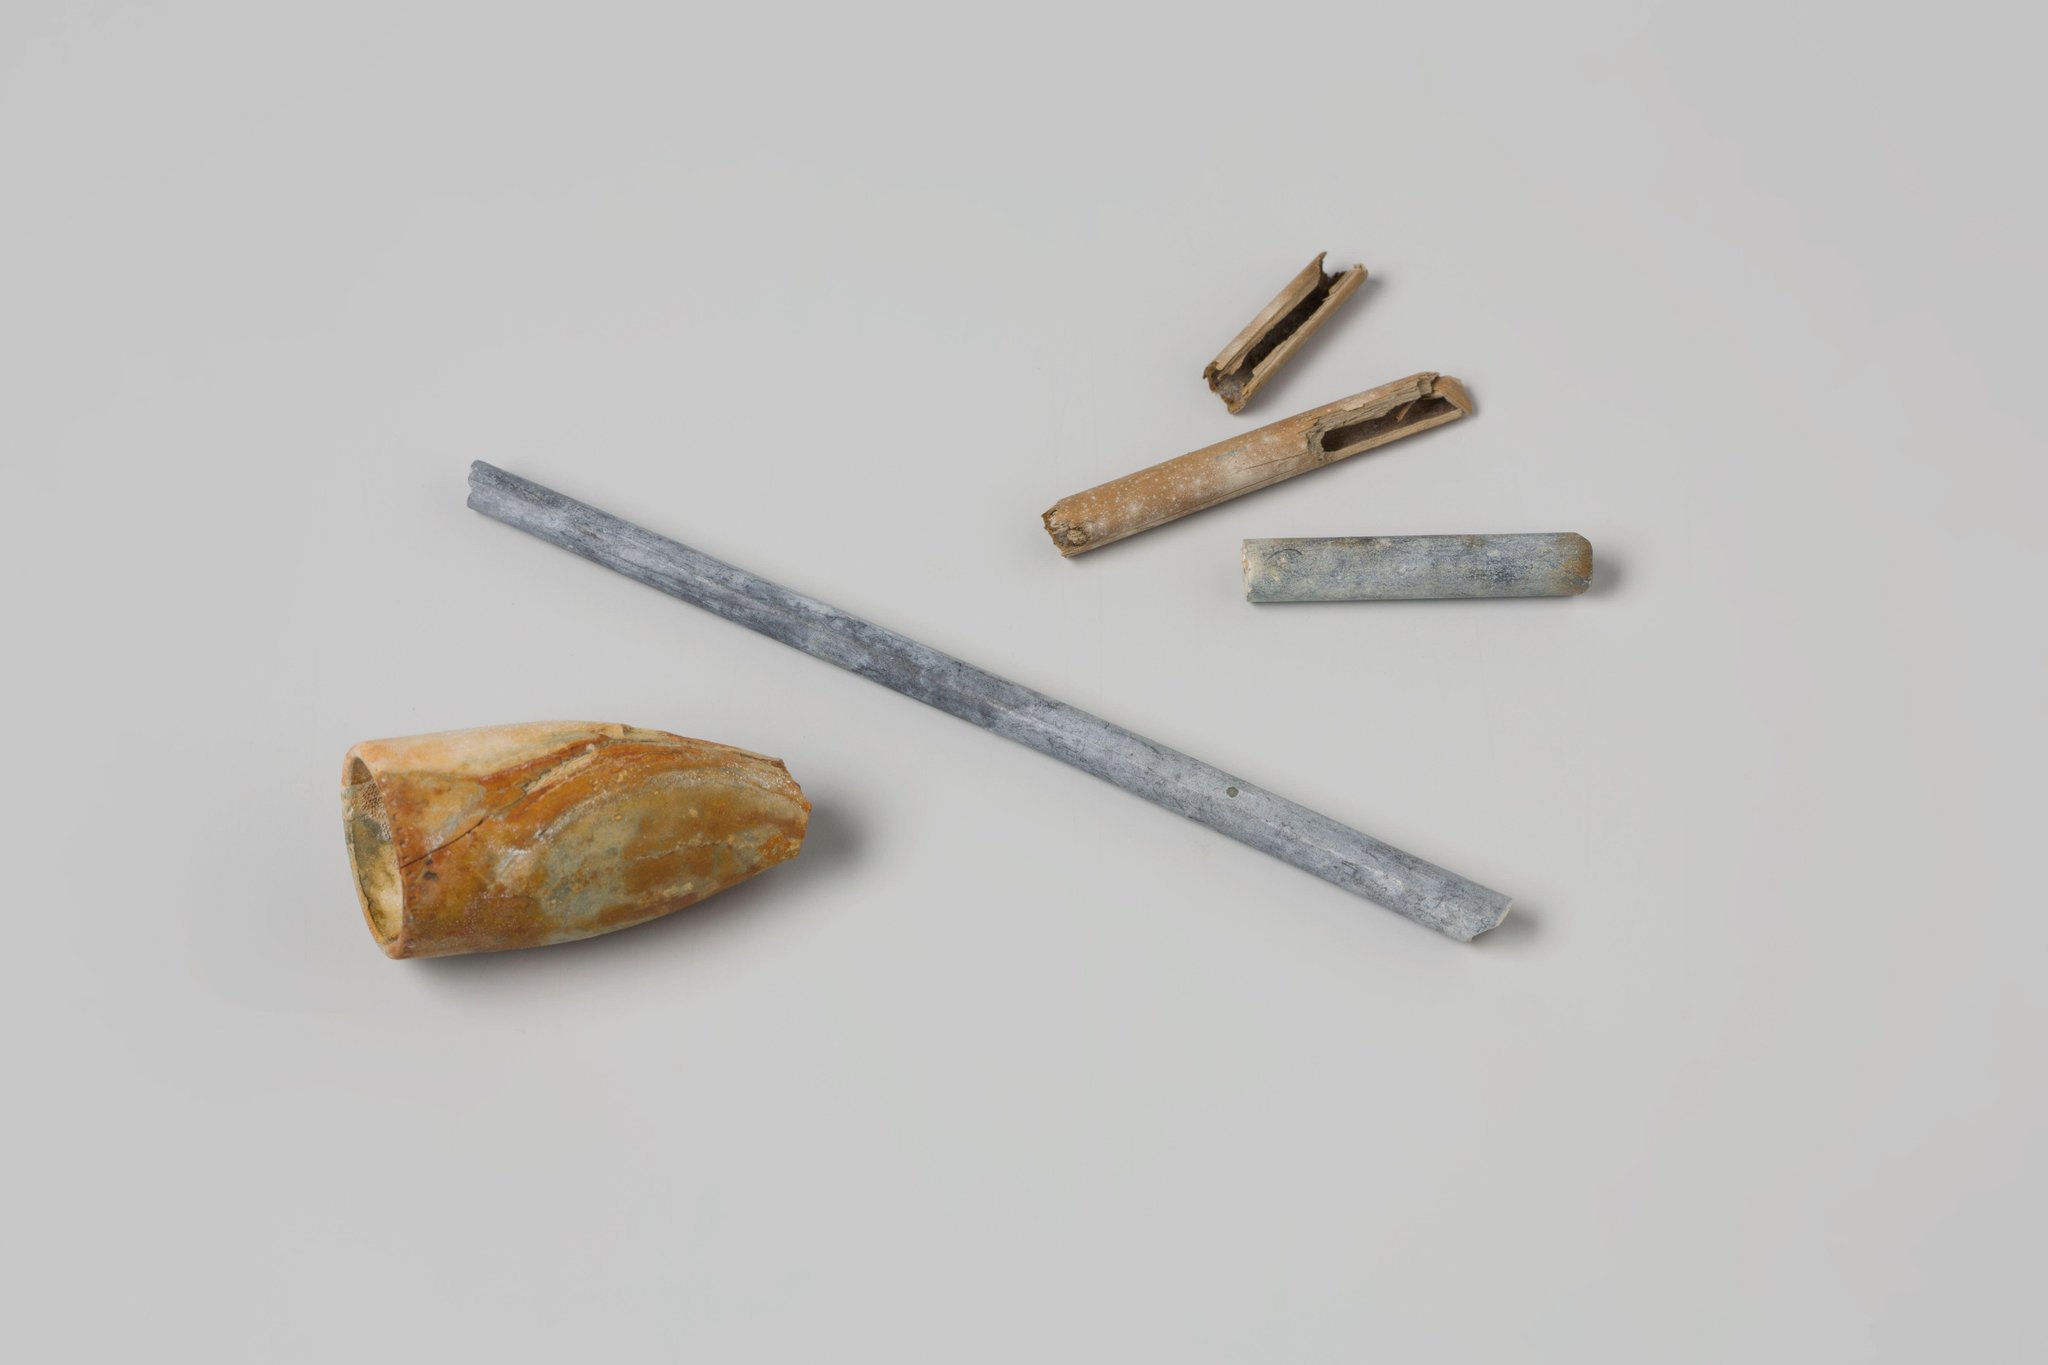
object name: pipe stem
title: Fragment van een pijpenkop en pijpenstelen uit het wrak van de Oost-Indiëvaarder 't Vliegend Hart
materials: clay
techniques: firing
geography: gouda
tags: 't vliegend hart (schip), verenigde oostindische compagnie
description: Een gebroken kop van een aarden Goudse pijp, met blauwrode metalige aankoekingen. Twee stukken steel.